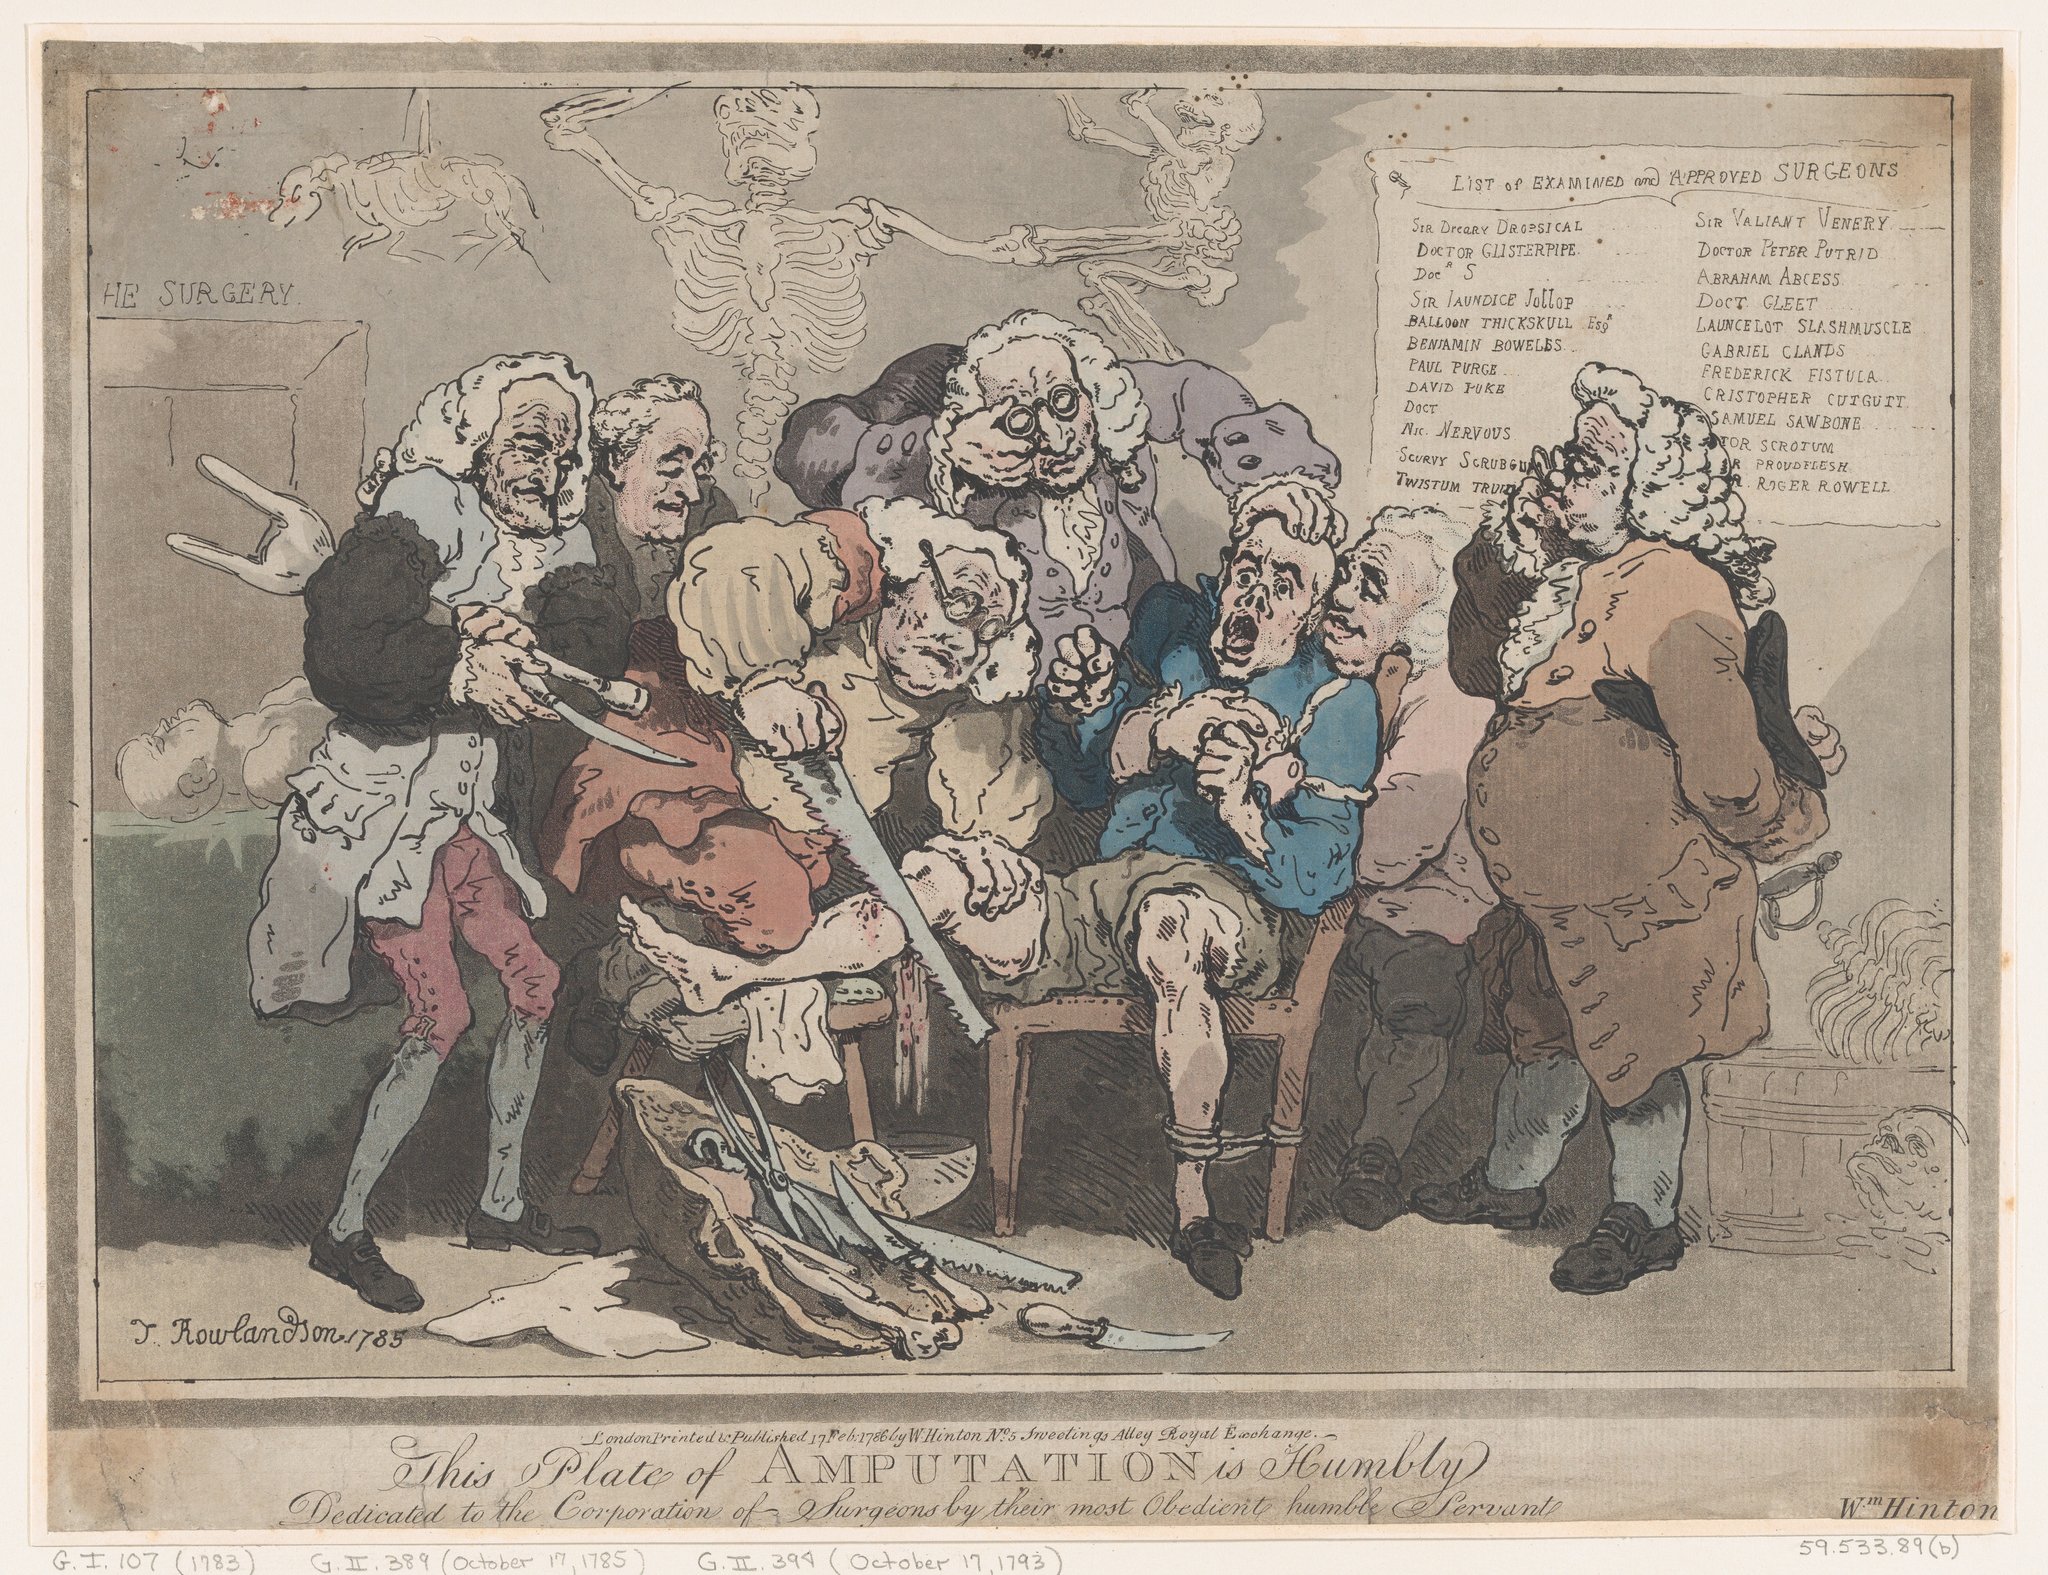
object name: print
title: Amputation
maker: thomas rowlandson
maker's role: artist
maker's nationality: british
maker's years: 1757-1827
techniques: etching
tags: satire,men,punishment